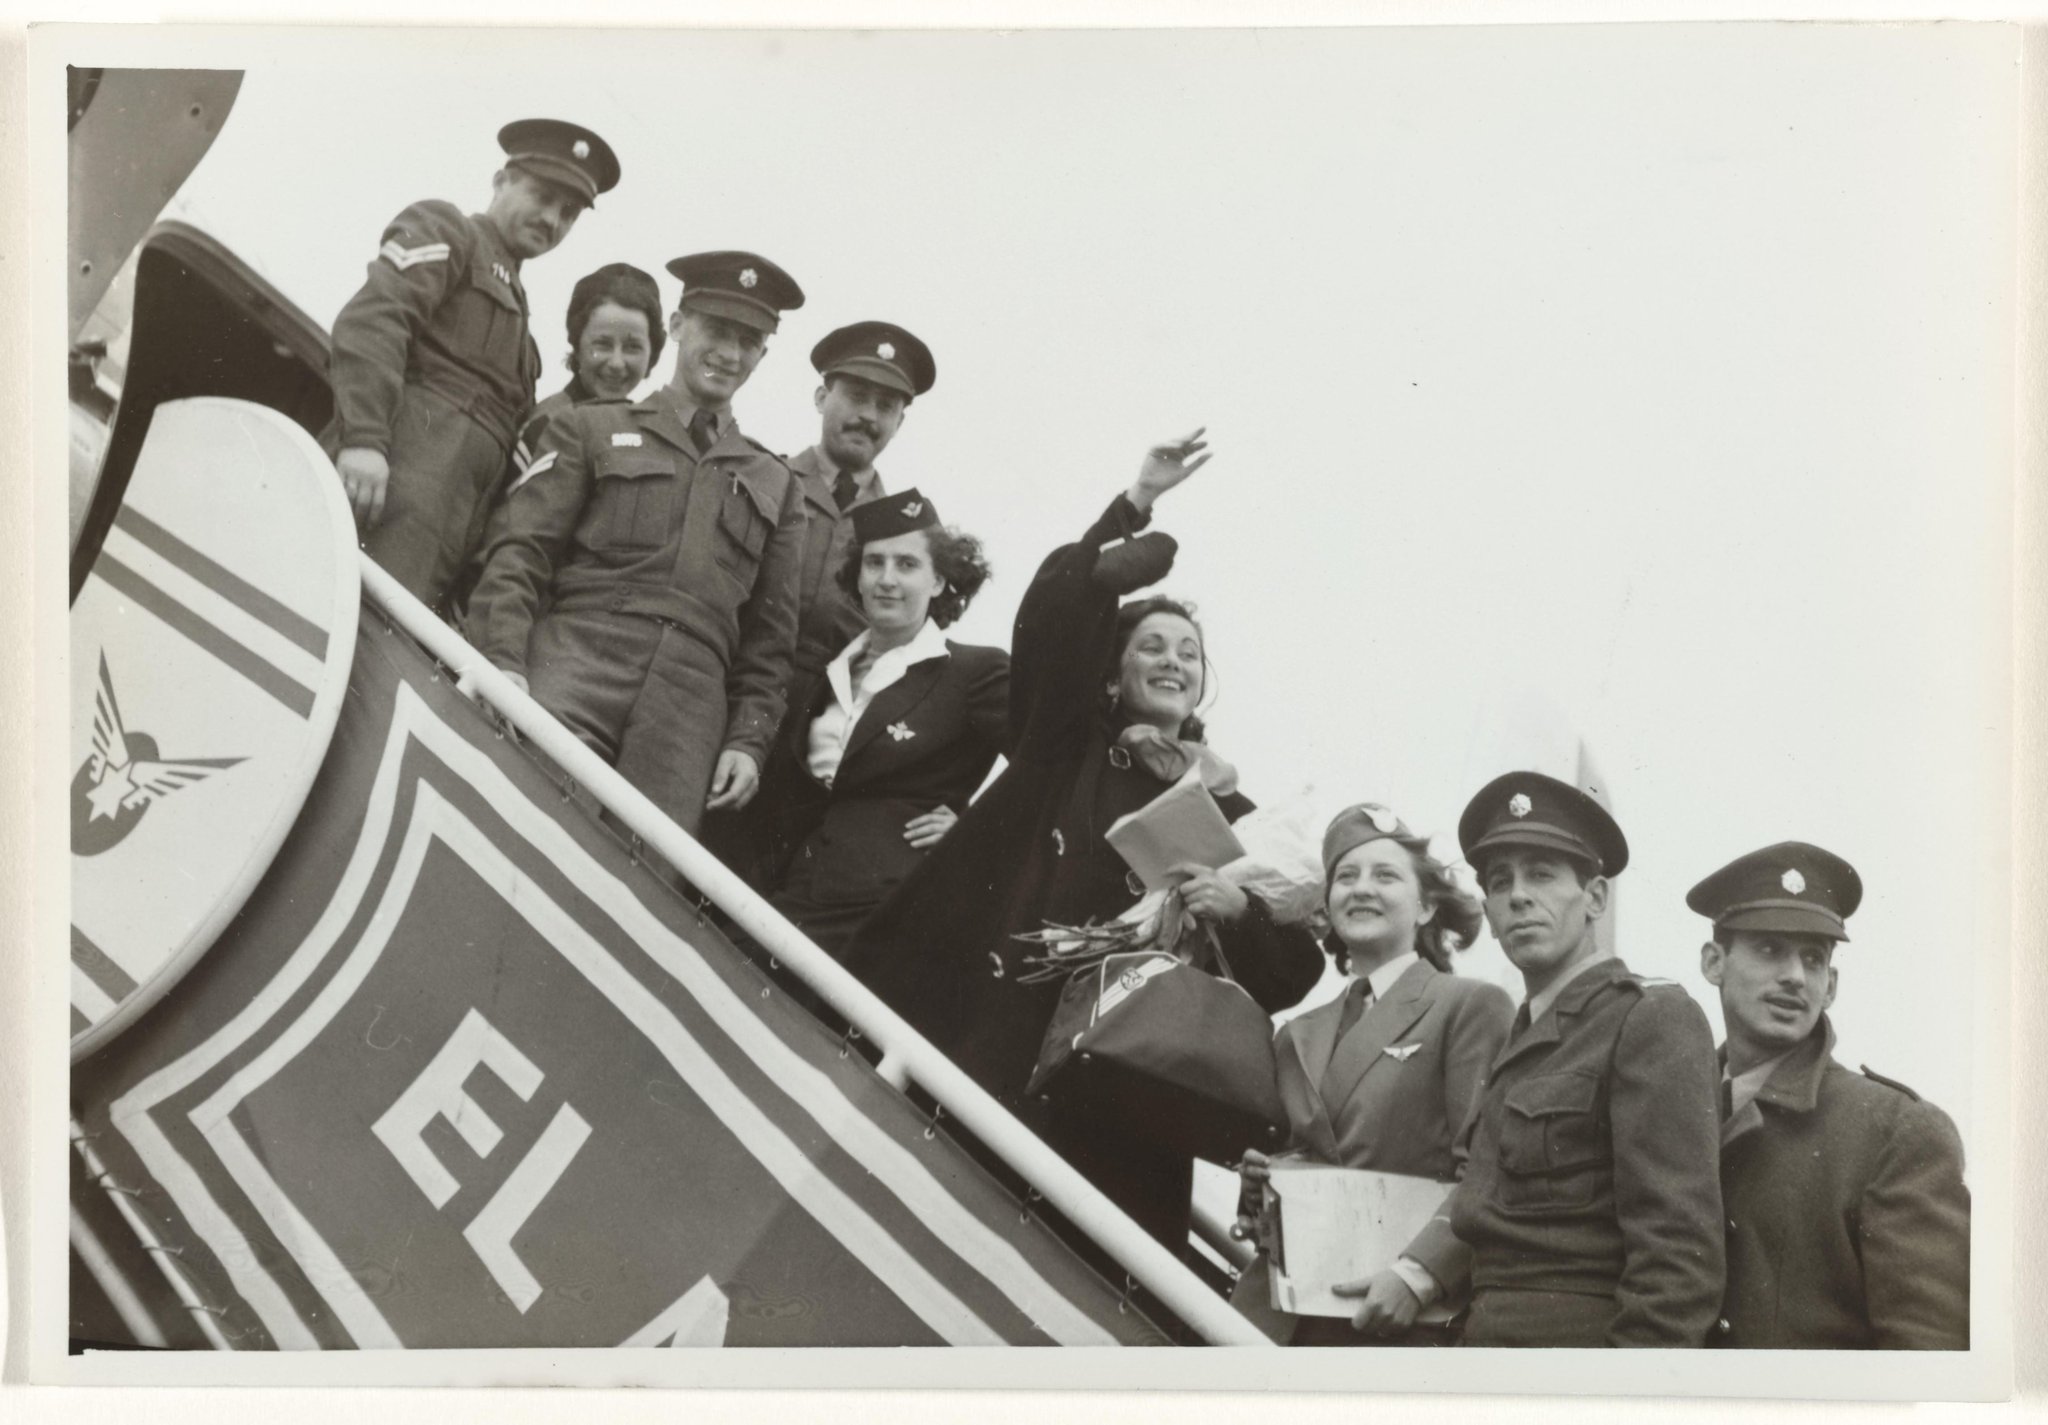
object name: photograph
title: Isabel Wachenheimer als medewerker van KLM met collega's op de toegangstrap naar een vliegtuig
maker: Anonymous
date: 1947-1956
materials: photographic support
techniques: gelatin silver print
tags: buchenwald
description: Isabel Wachenheimer (5e van links) en collega's.